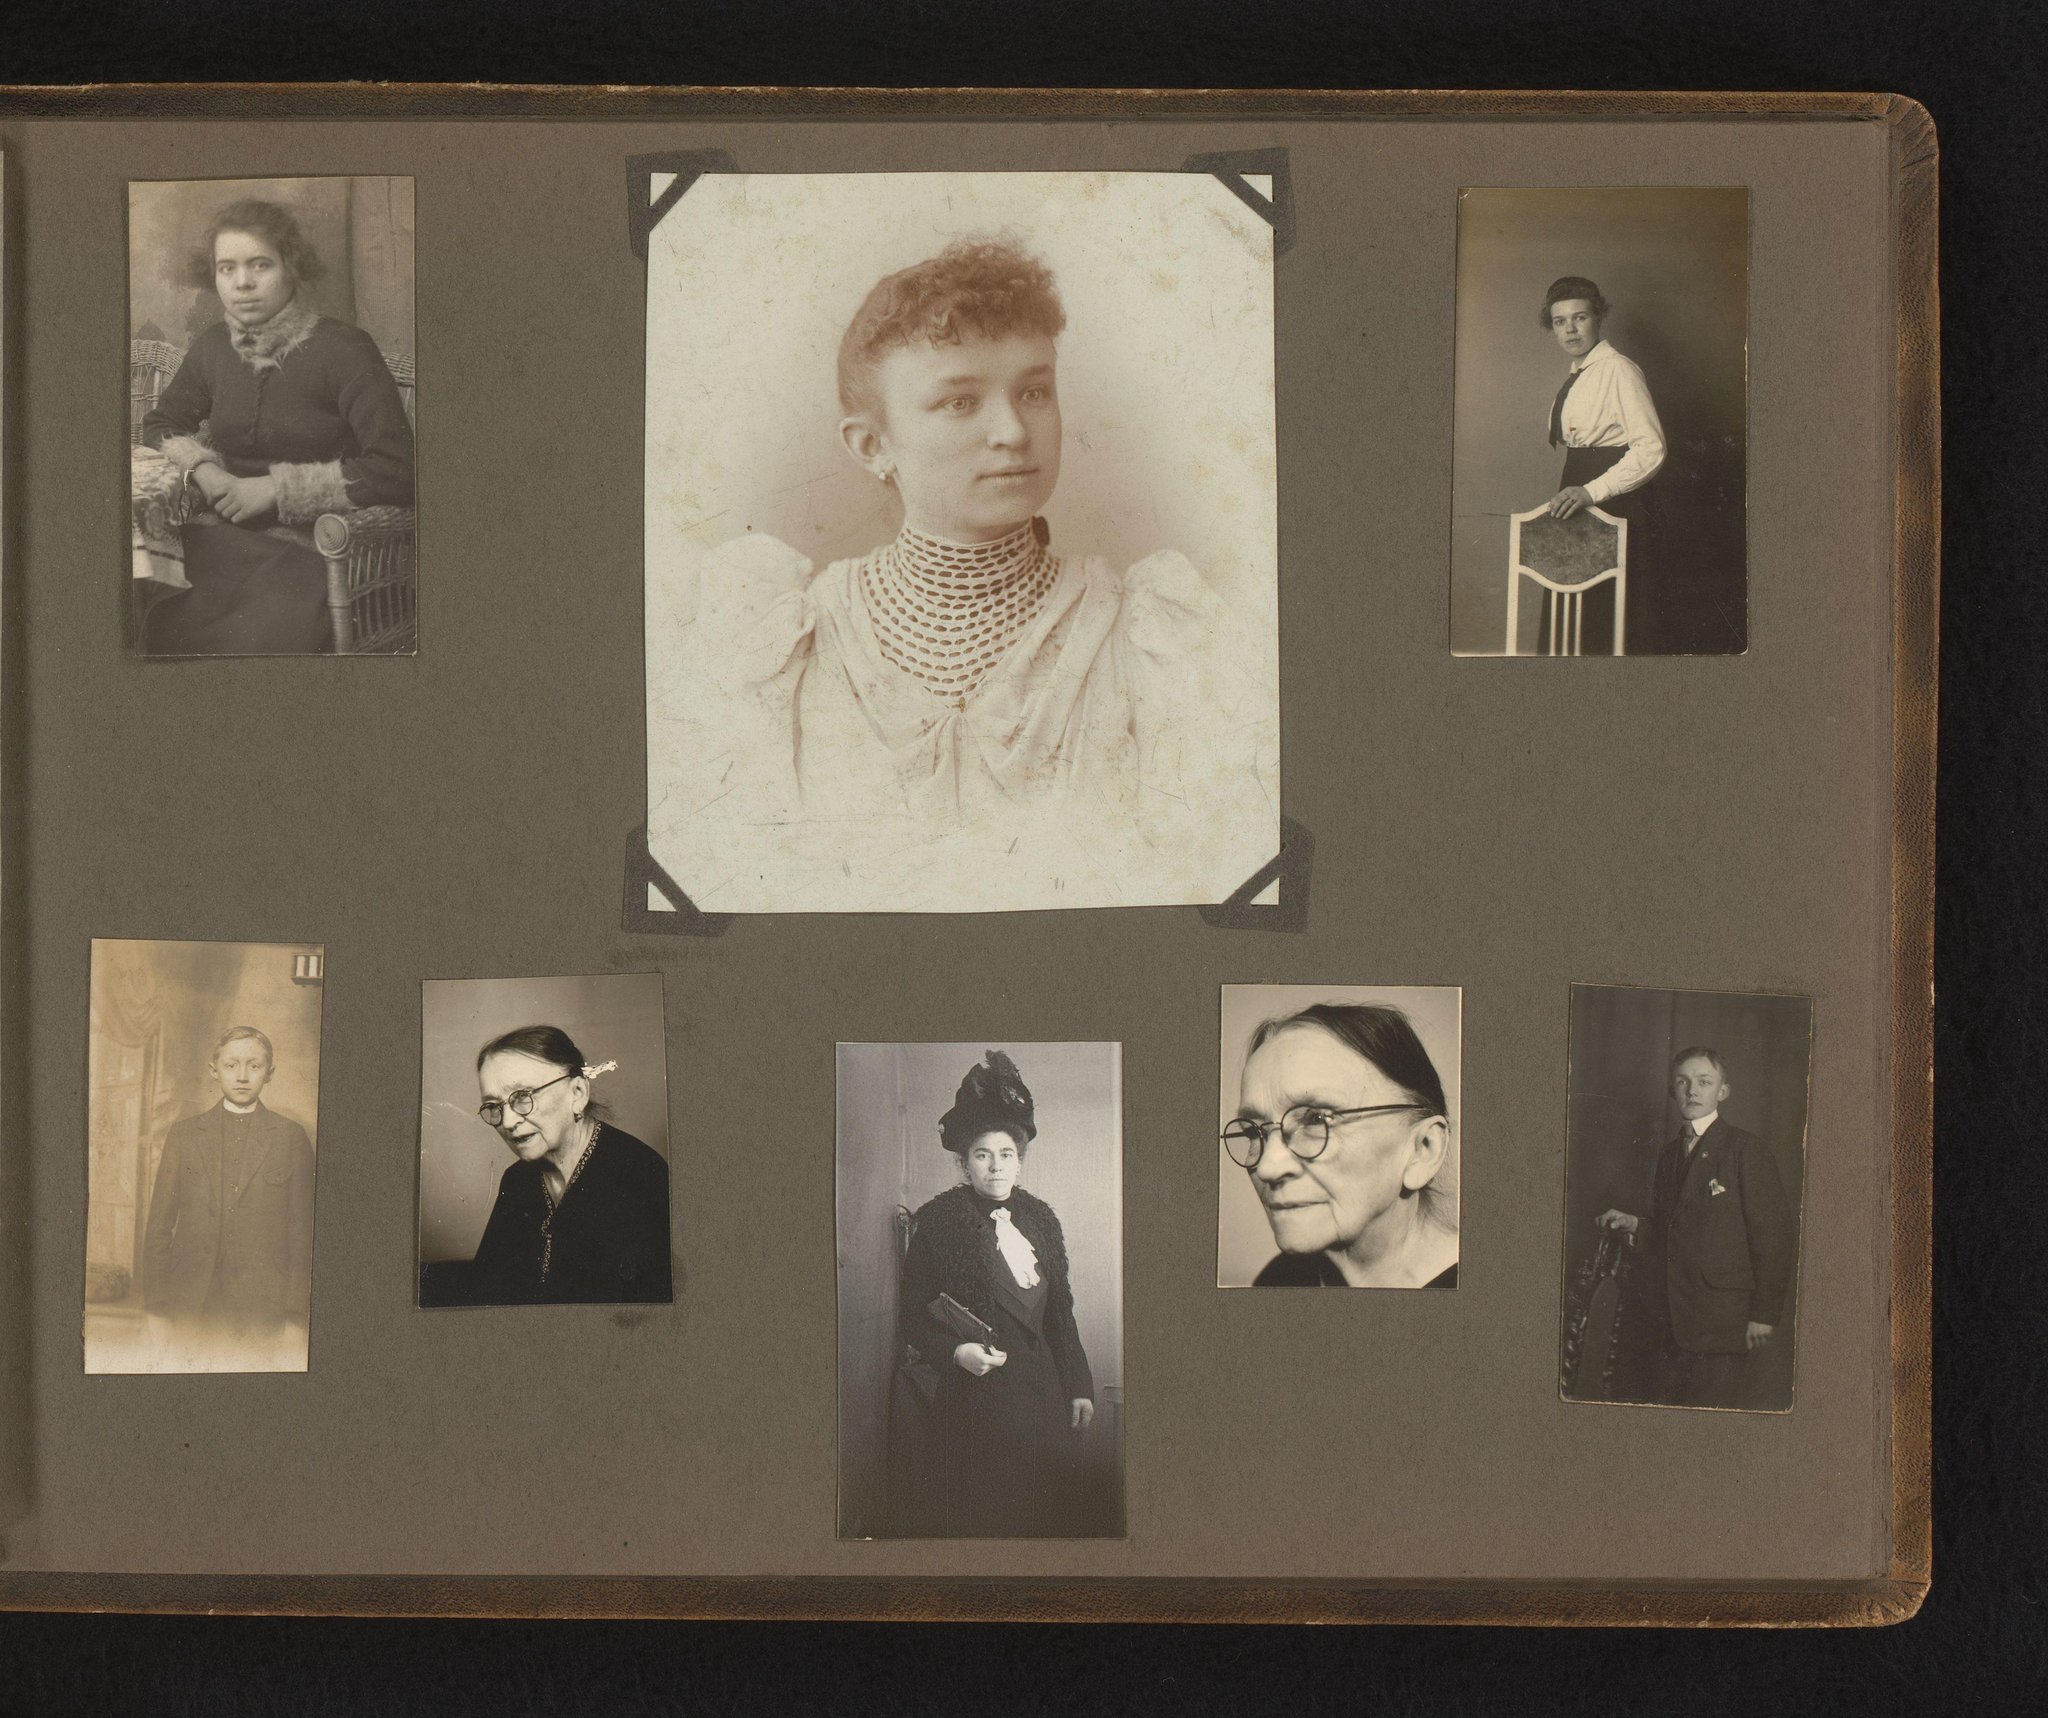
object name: album leaf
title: Portretten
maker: Anonymous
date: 1900-1950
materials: photographic support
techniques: gelatin silver print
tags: eyeglasses, spectacles, adolescent, young woman, maiden, adult woman, historical persons, youth, adolescent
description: Drie portretten van vrouwen, drie portretten van jonge vrouwen en twee portretten van een jonge man. Deze pagina maakt deel uit van een album.